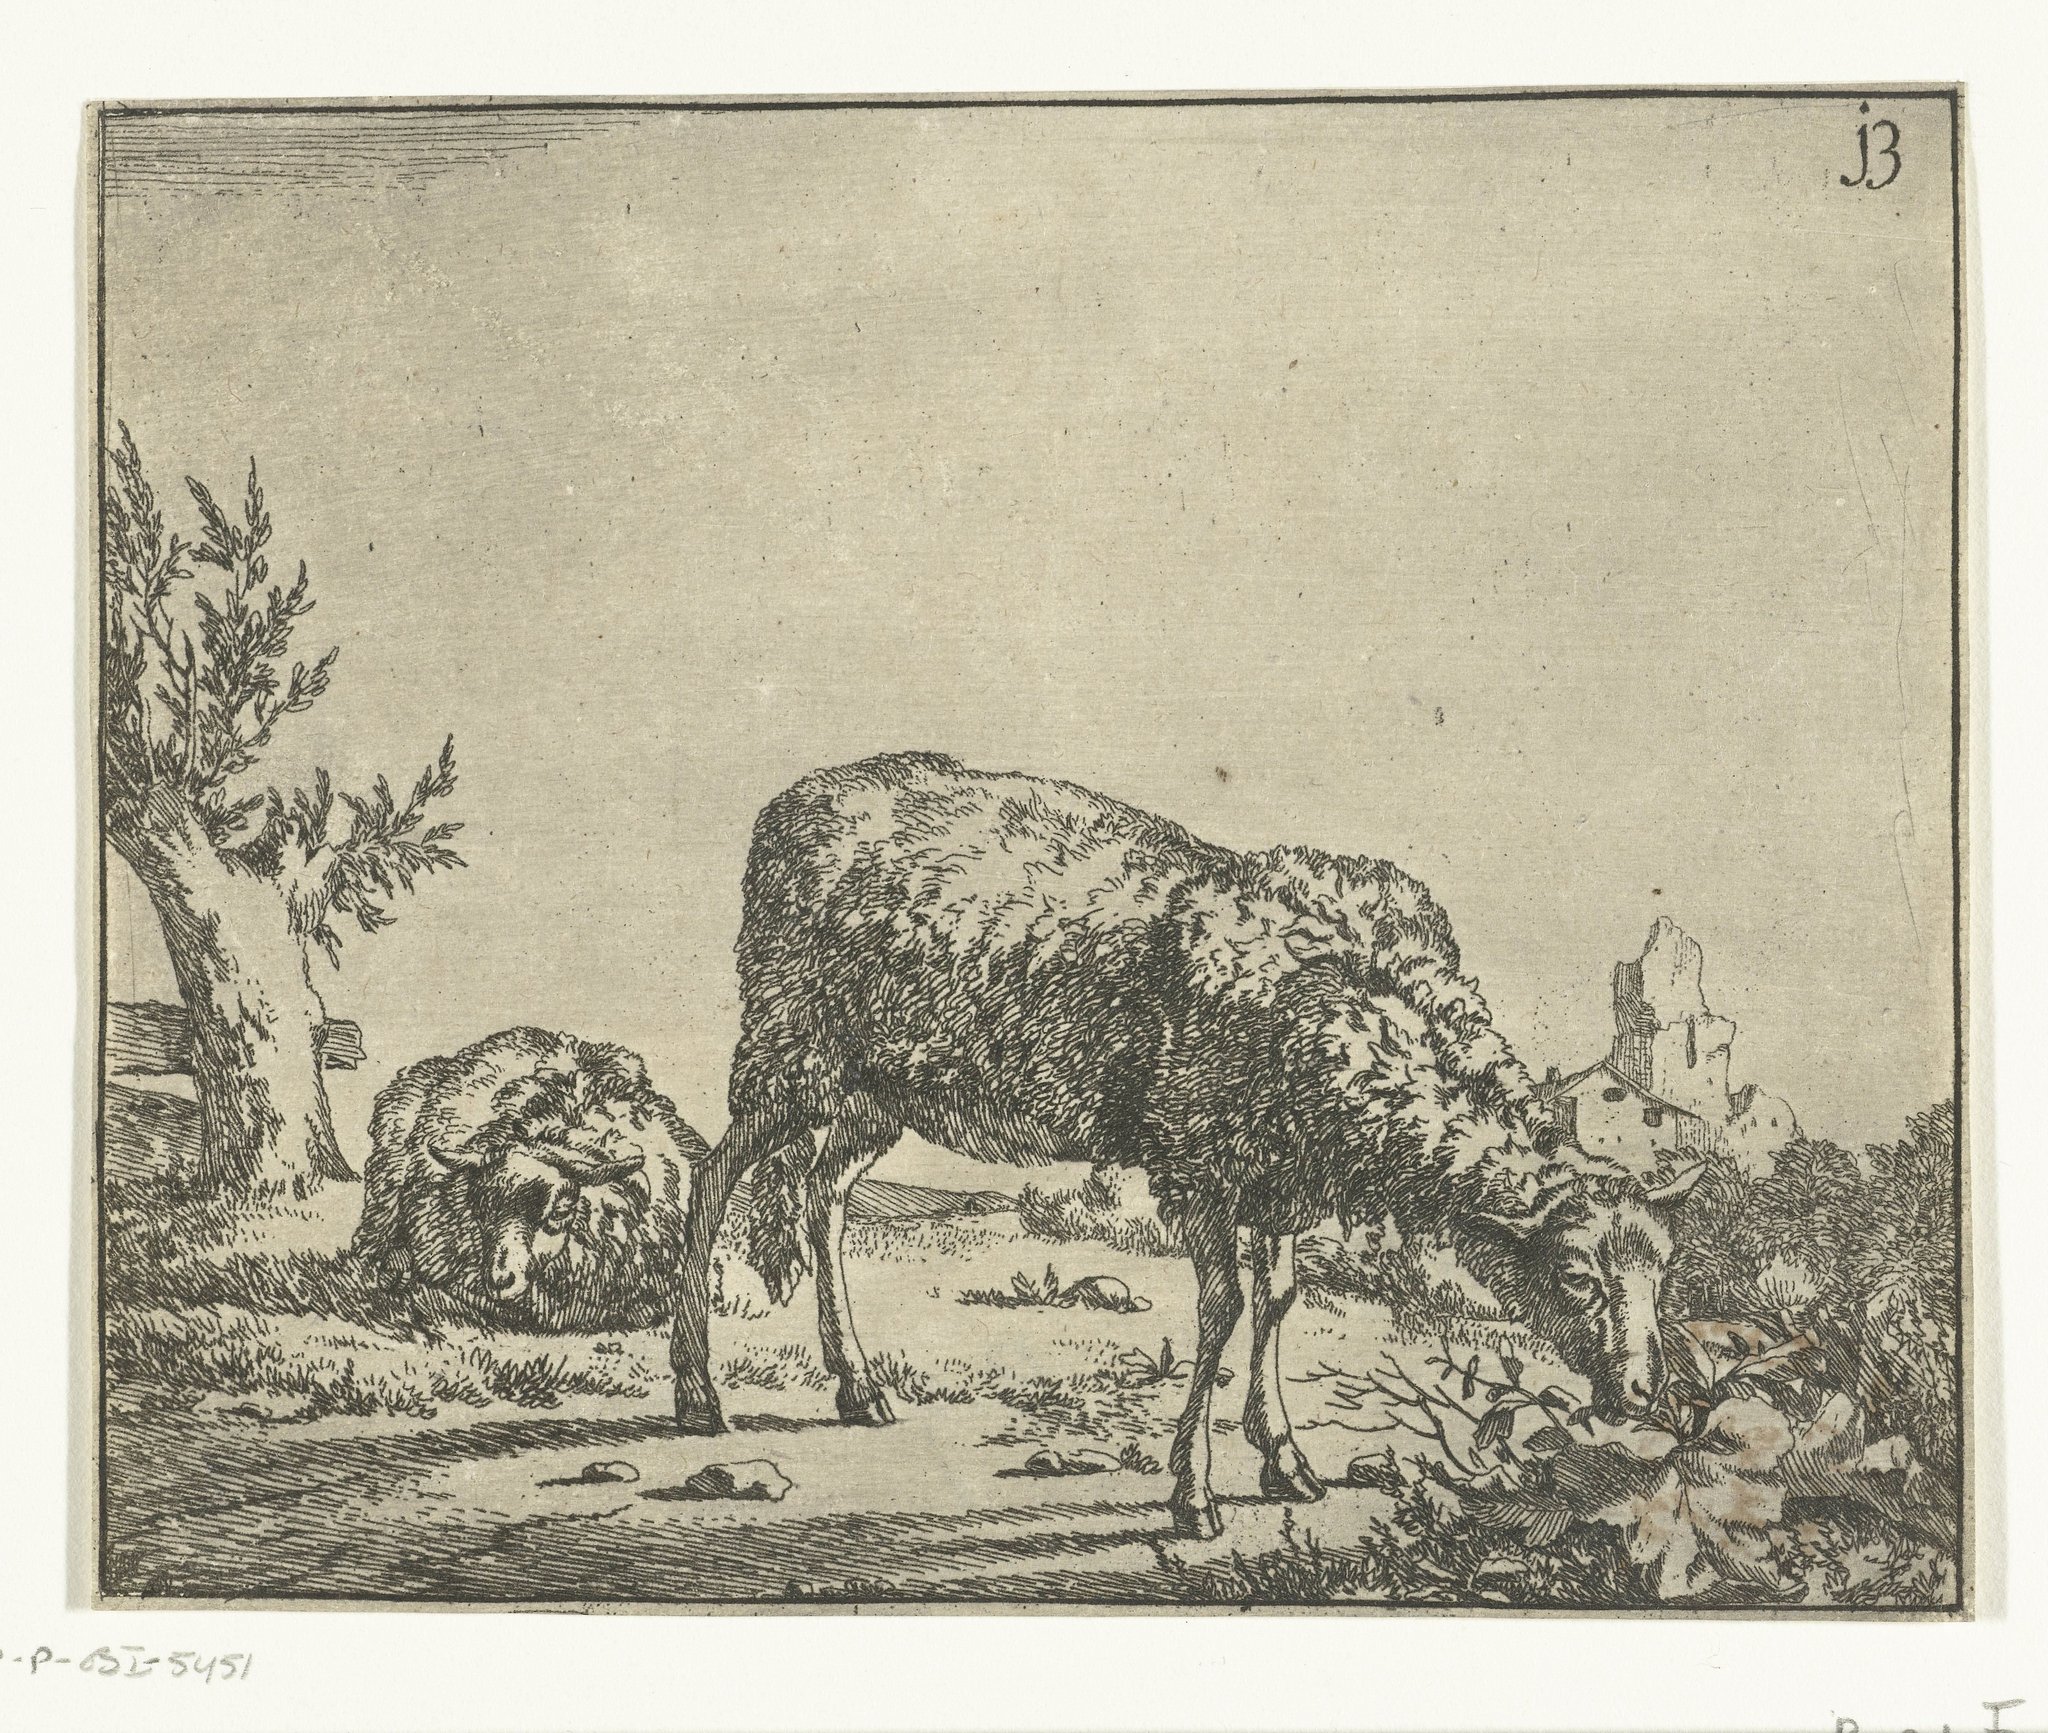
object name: print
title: Grazend schaap en liggend schaap bij hek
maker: marcus de bye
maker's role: print maker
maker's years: 1639-1688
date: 1660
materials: paper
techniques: etching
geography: the hague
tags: sheep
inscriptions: collector's mark: Lugt 240